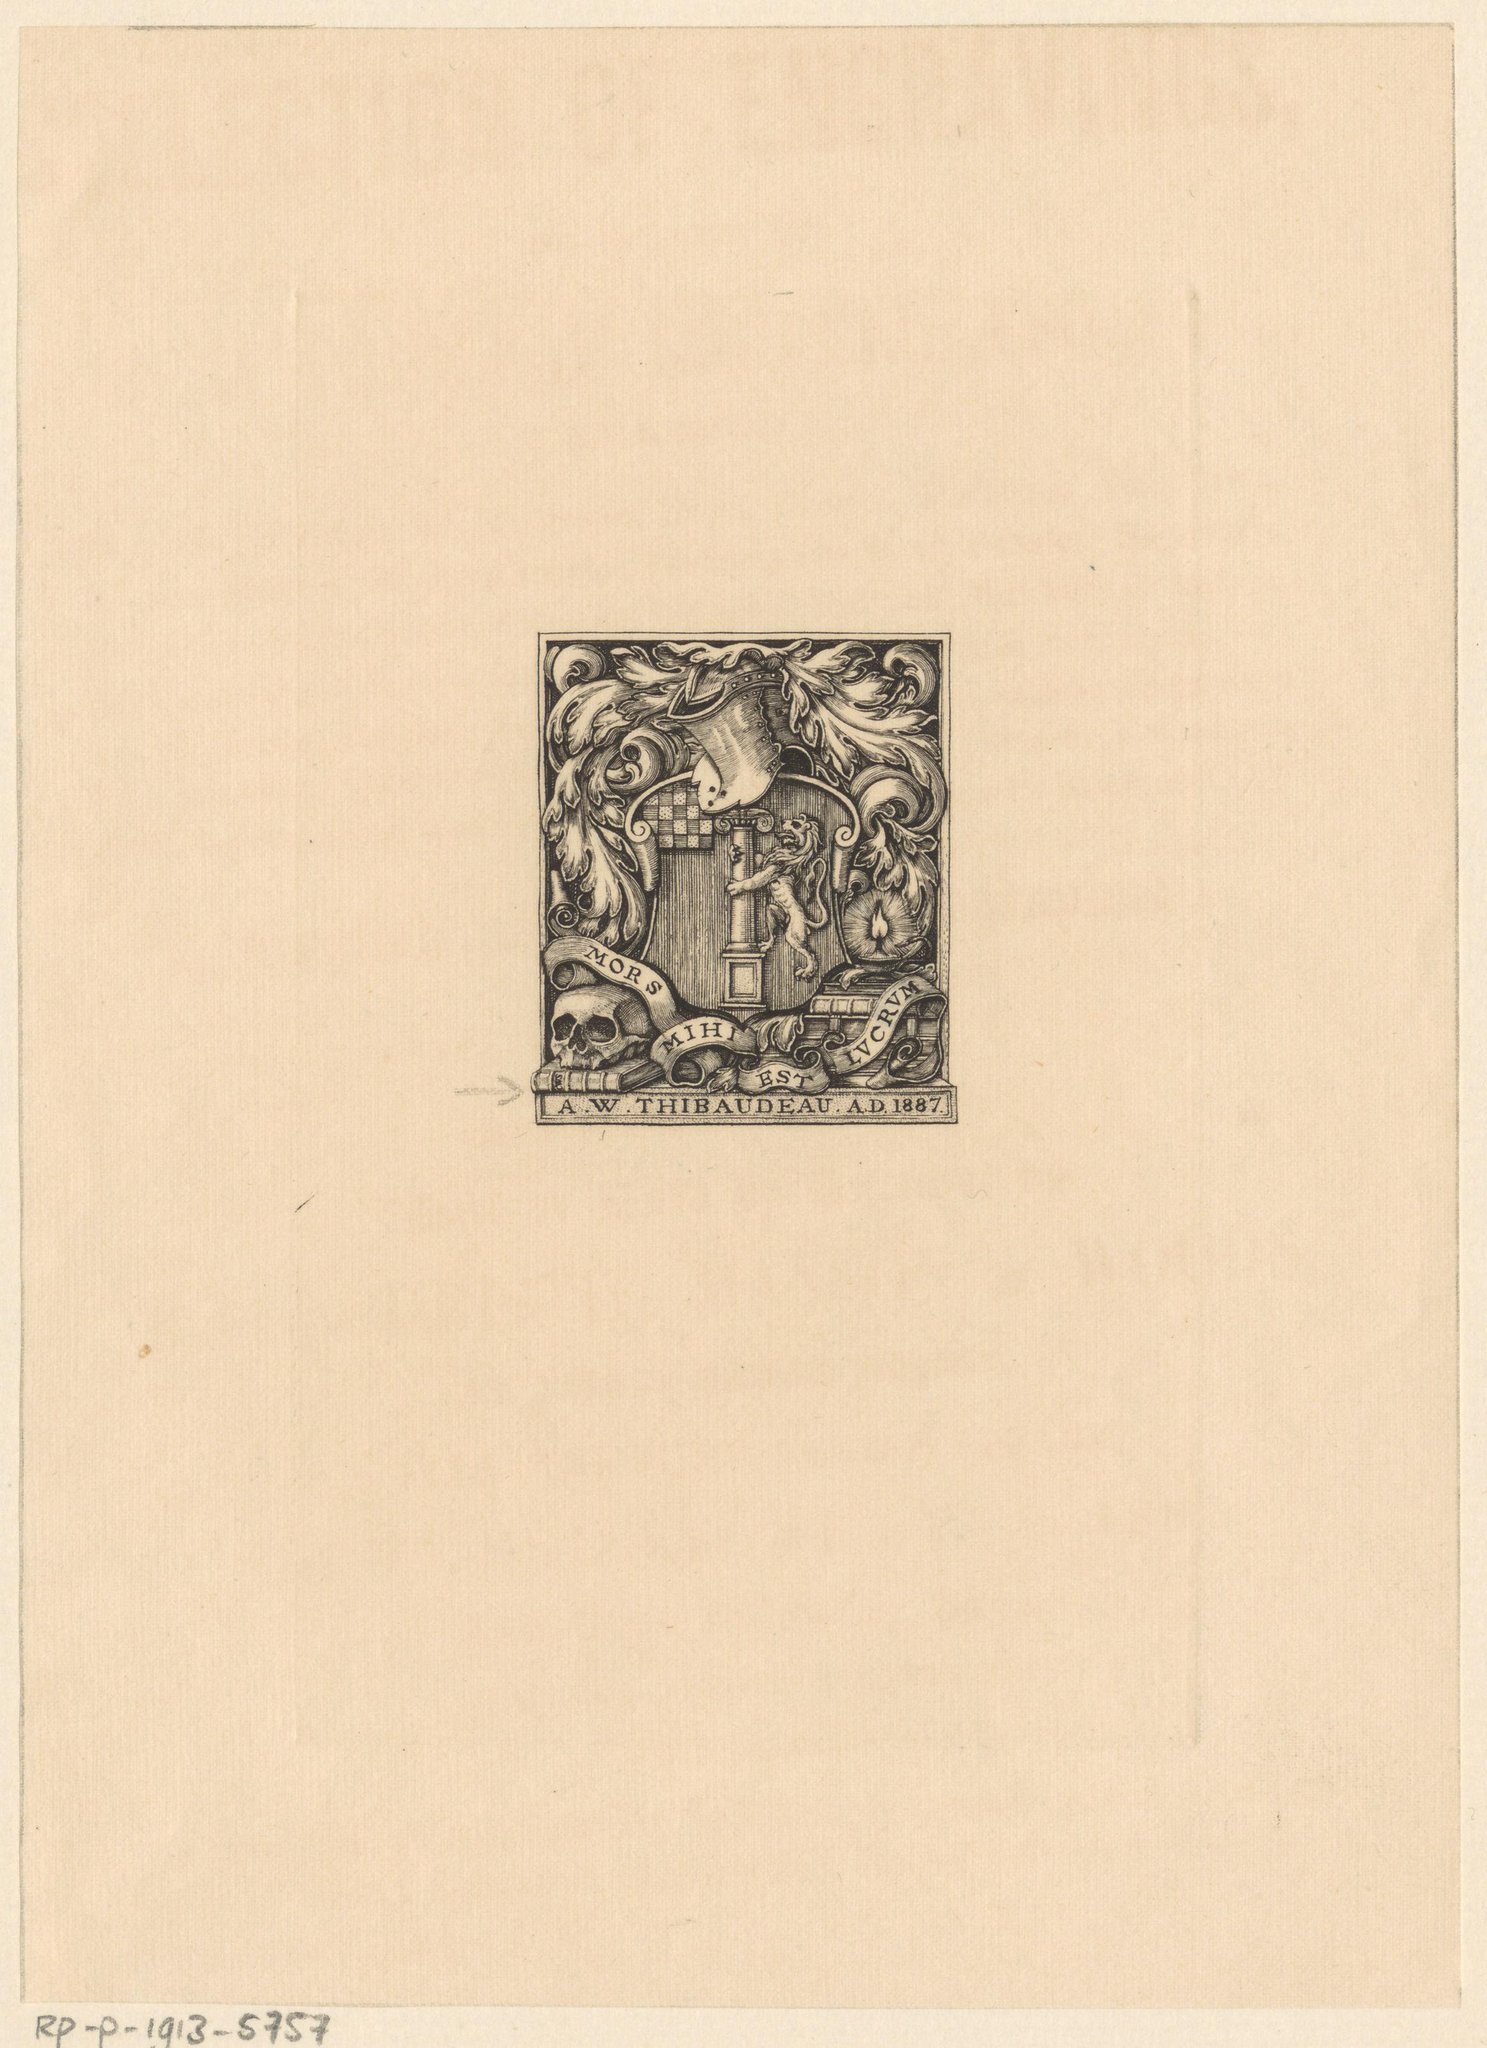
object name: bookplate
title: Mors mihi est lucrum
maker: charles william sherborn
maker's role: print maker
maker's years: 1831-1912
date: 1887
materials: paper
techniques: engraving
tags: armorial bearing, heraldry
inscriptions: collector's mark: Lugt 2760, collector's mark: Lugt 2233